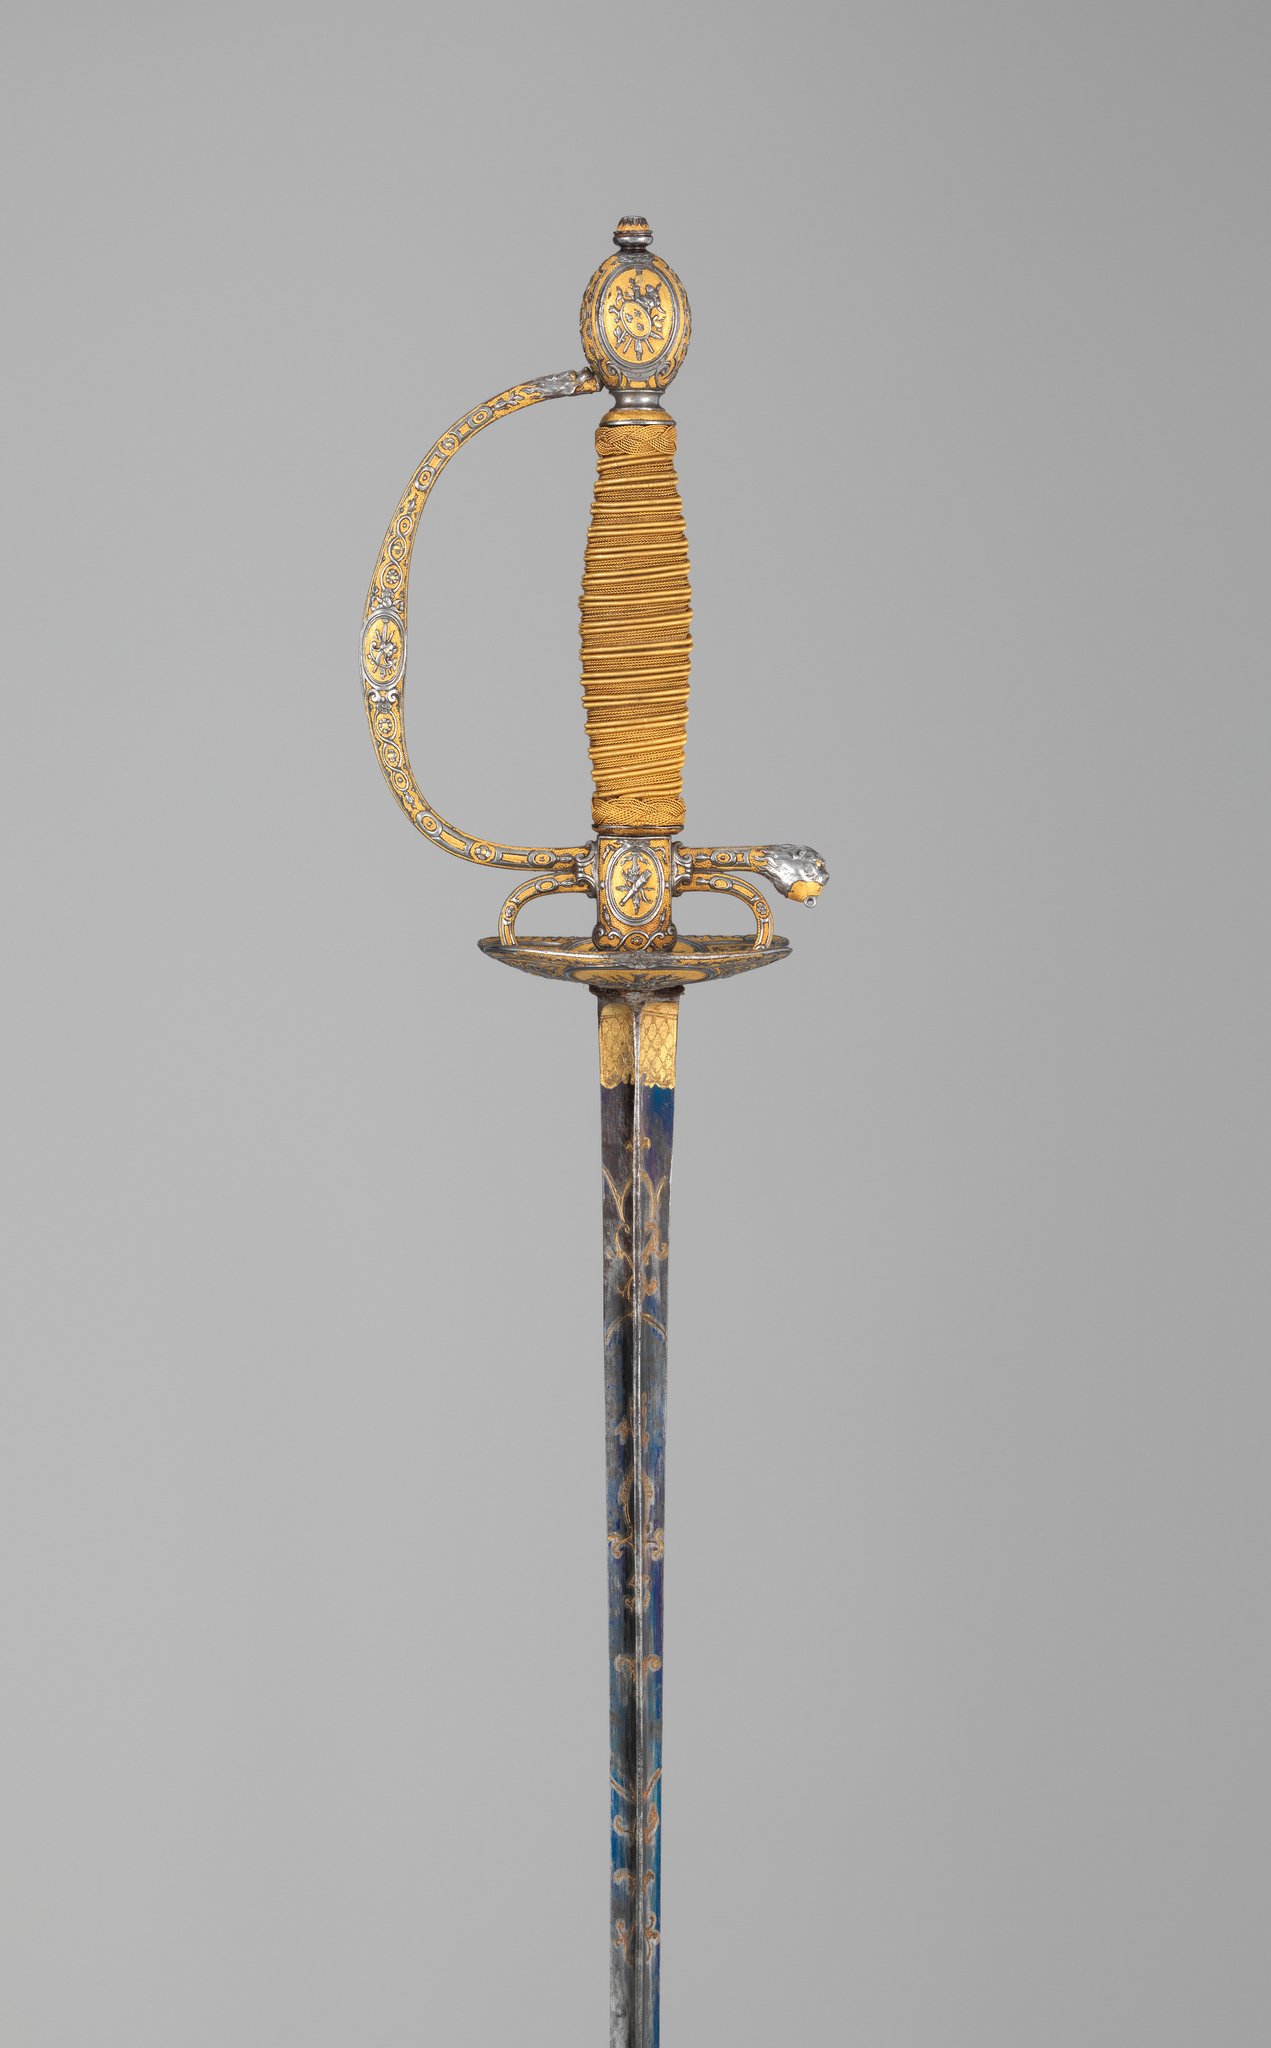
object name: smallsword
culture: french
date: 1780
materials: gold, steel, textile, wood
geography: france